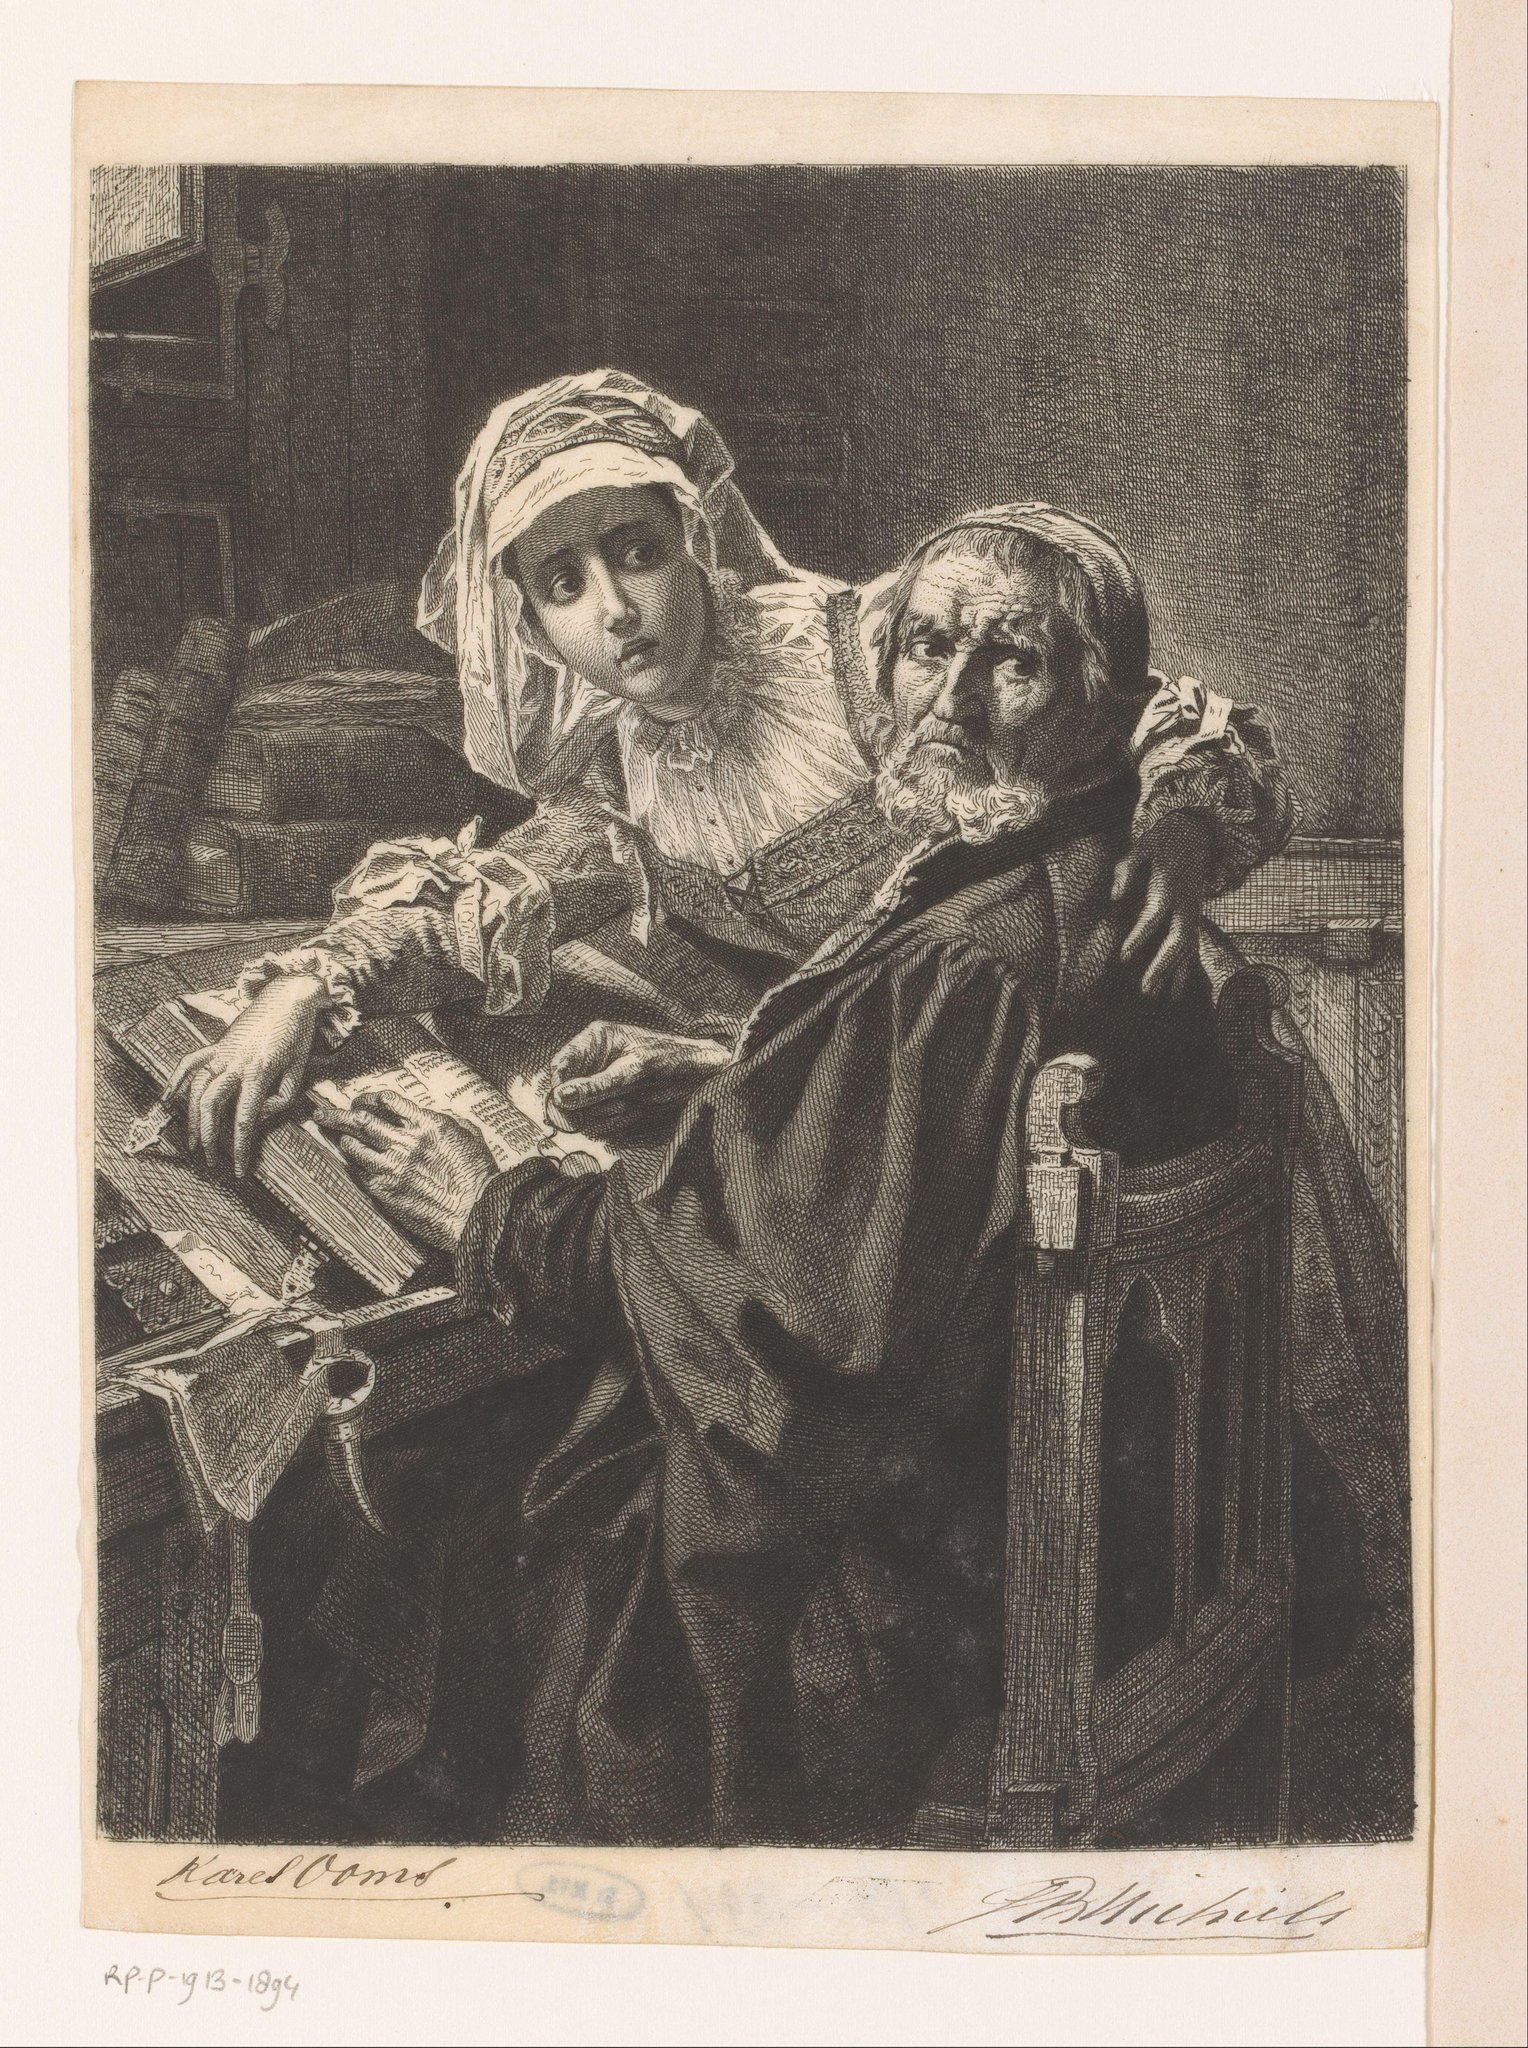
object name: print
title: Oude man en een vrouw lezen verboden lectuur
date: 1876-1890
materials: parchment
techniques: etching, intaglio, roulette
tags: adolescent, young woman, maiden, reading, old man, reading the bible or other religious books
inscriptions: collector's mark: Lugt 2228